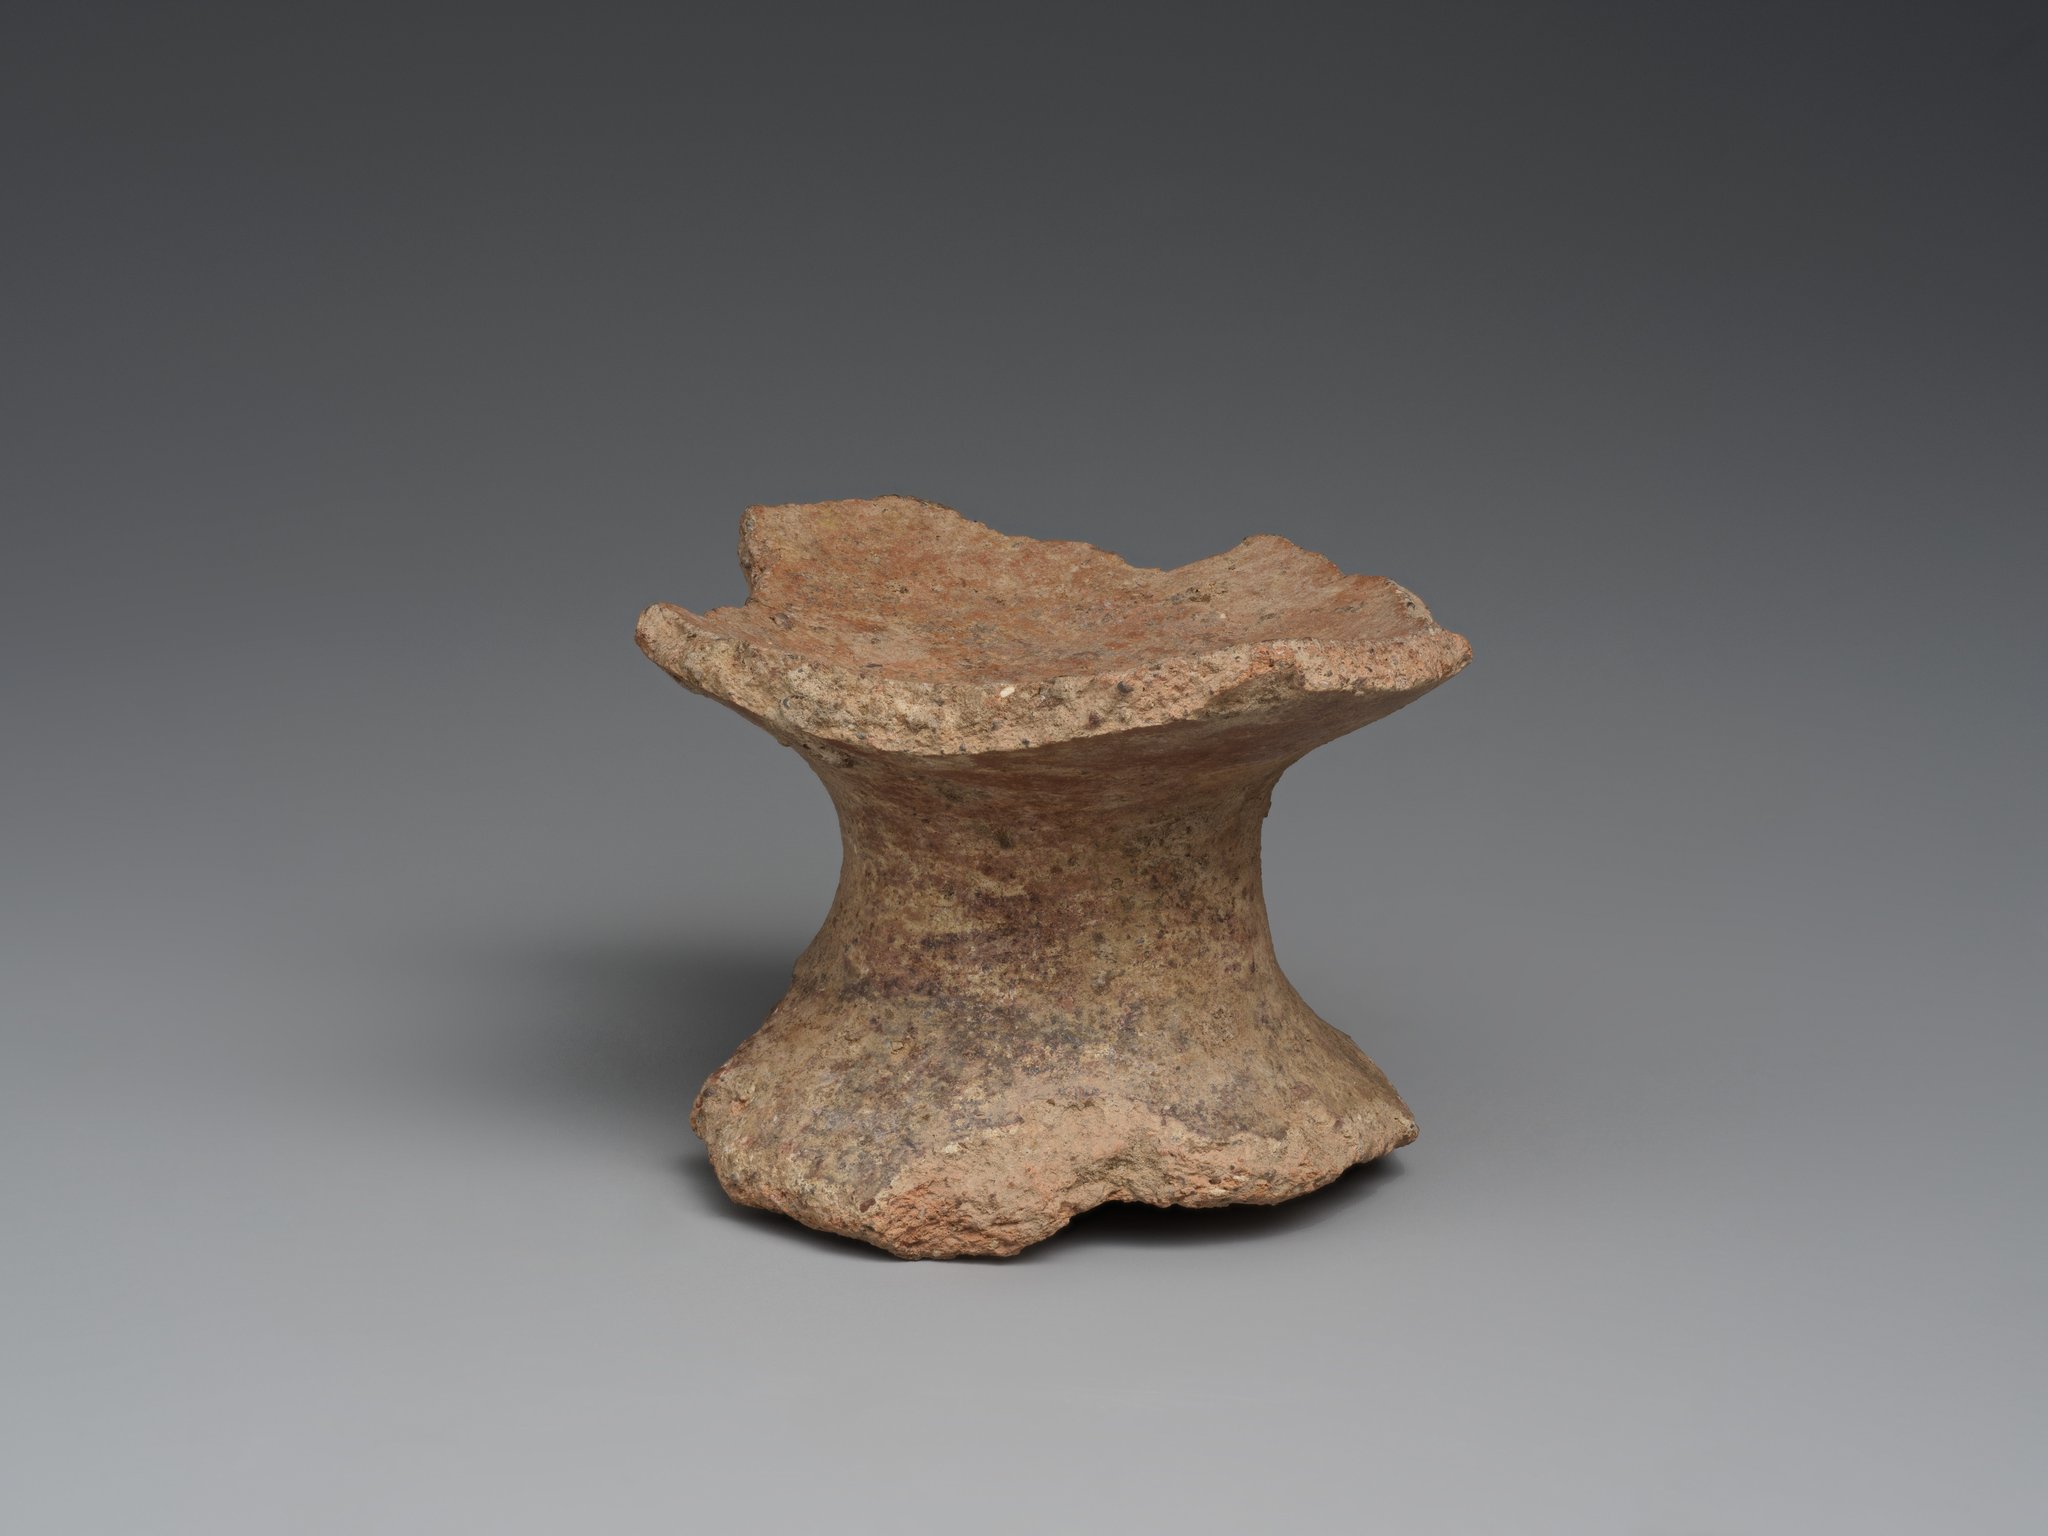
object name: sherd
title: Base sherd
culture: iranian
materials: ceramic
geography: iran